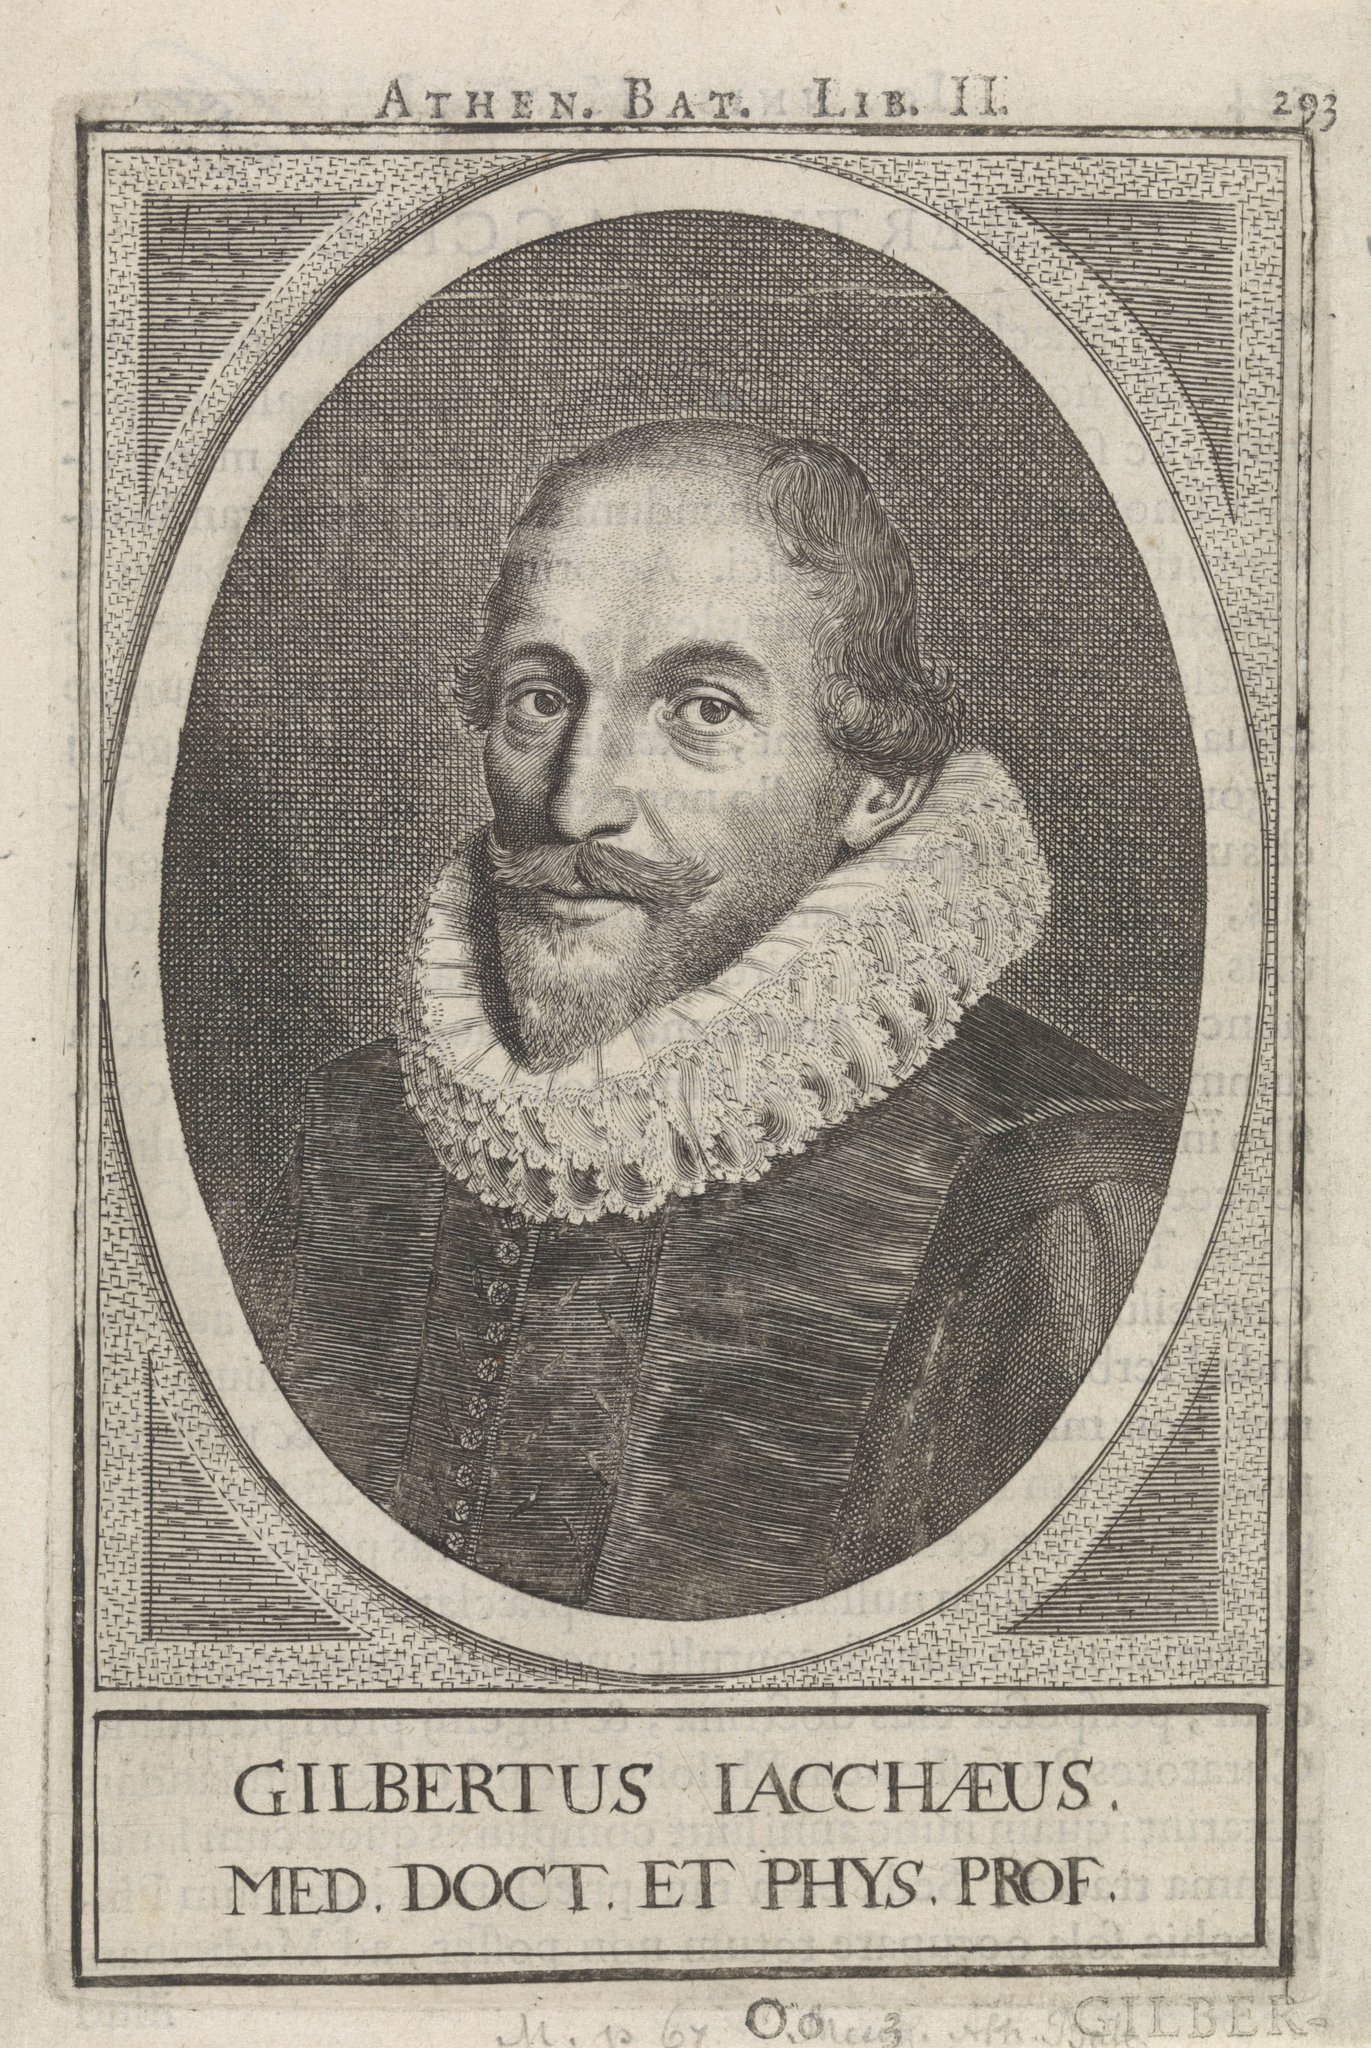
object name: book illustration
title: Portret van Jacchaeus Gilbertus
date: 1625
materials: paper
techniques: engraving, letterpress printing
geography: leiden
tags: leiden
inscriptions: collector's mark: Lugt 2228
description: Boekillustratie in: Meursius, Joannes. Athenæ Batavæ. Sive, De vrbe Leidensi, & academiâ, virisque claris. Leiden: Andries Clouck, Bonaventura en Abraham Elzevier, 1625. Abusievelijk tweemaal gecatalogiseerd bij Franken & Van der Kellen.